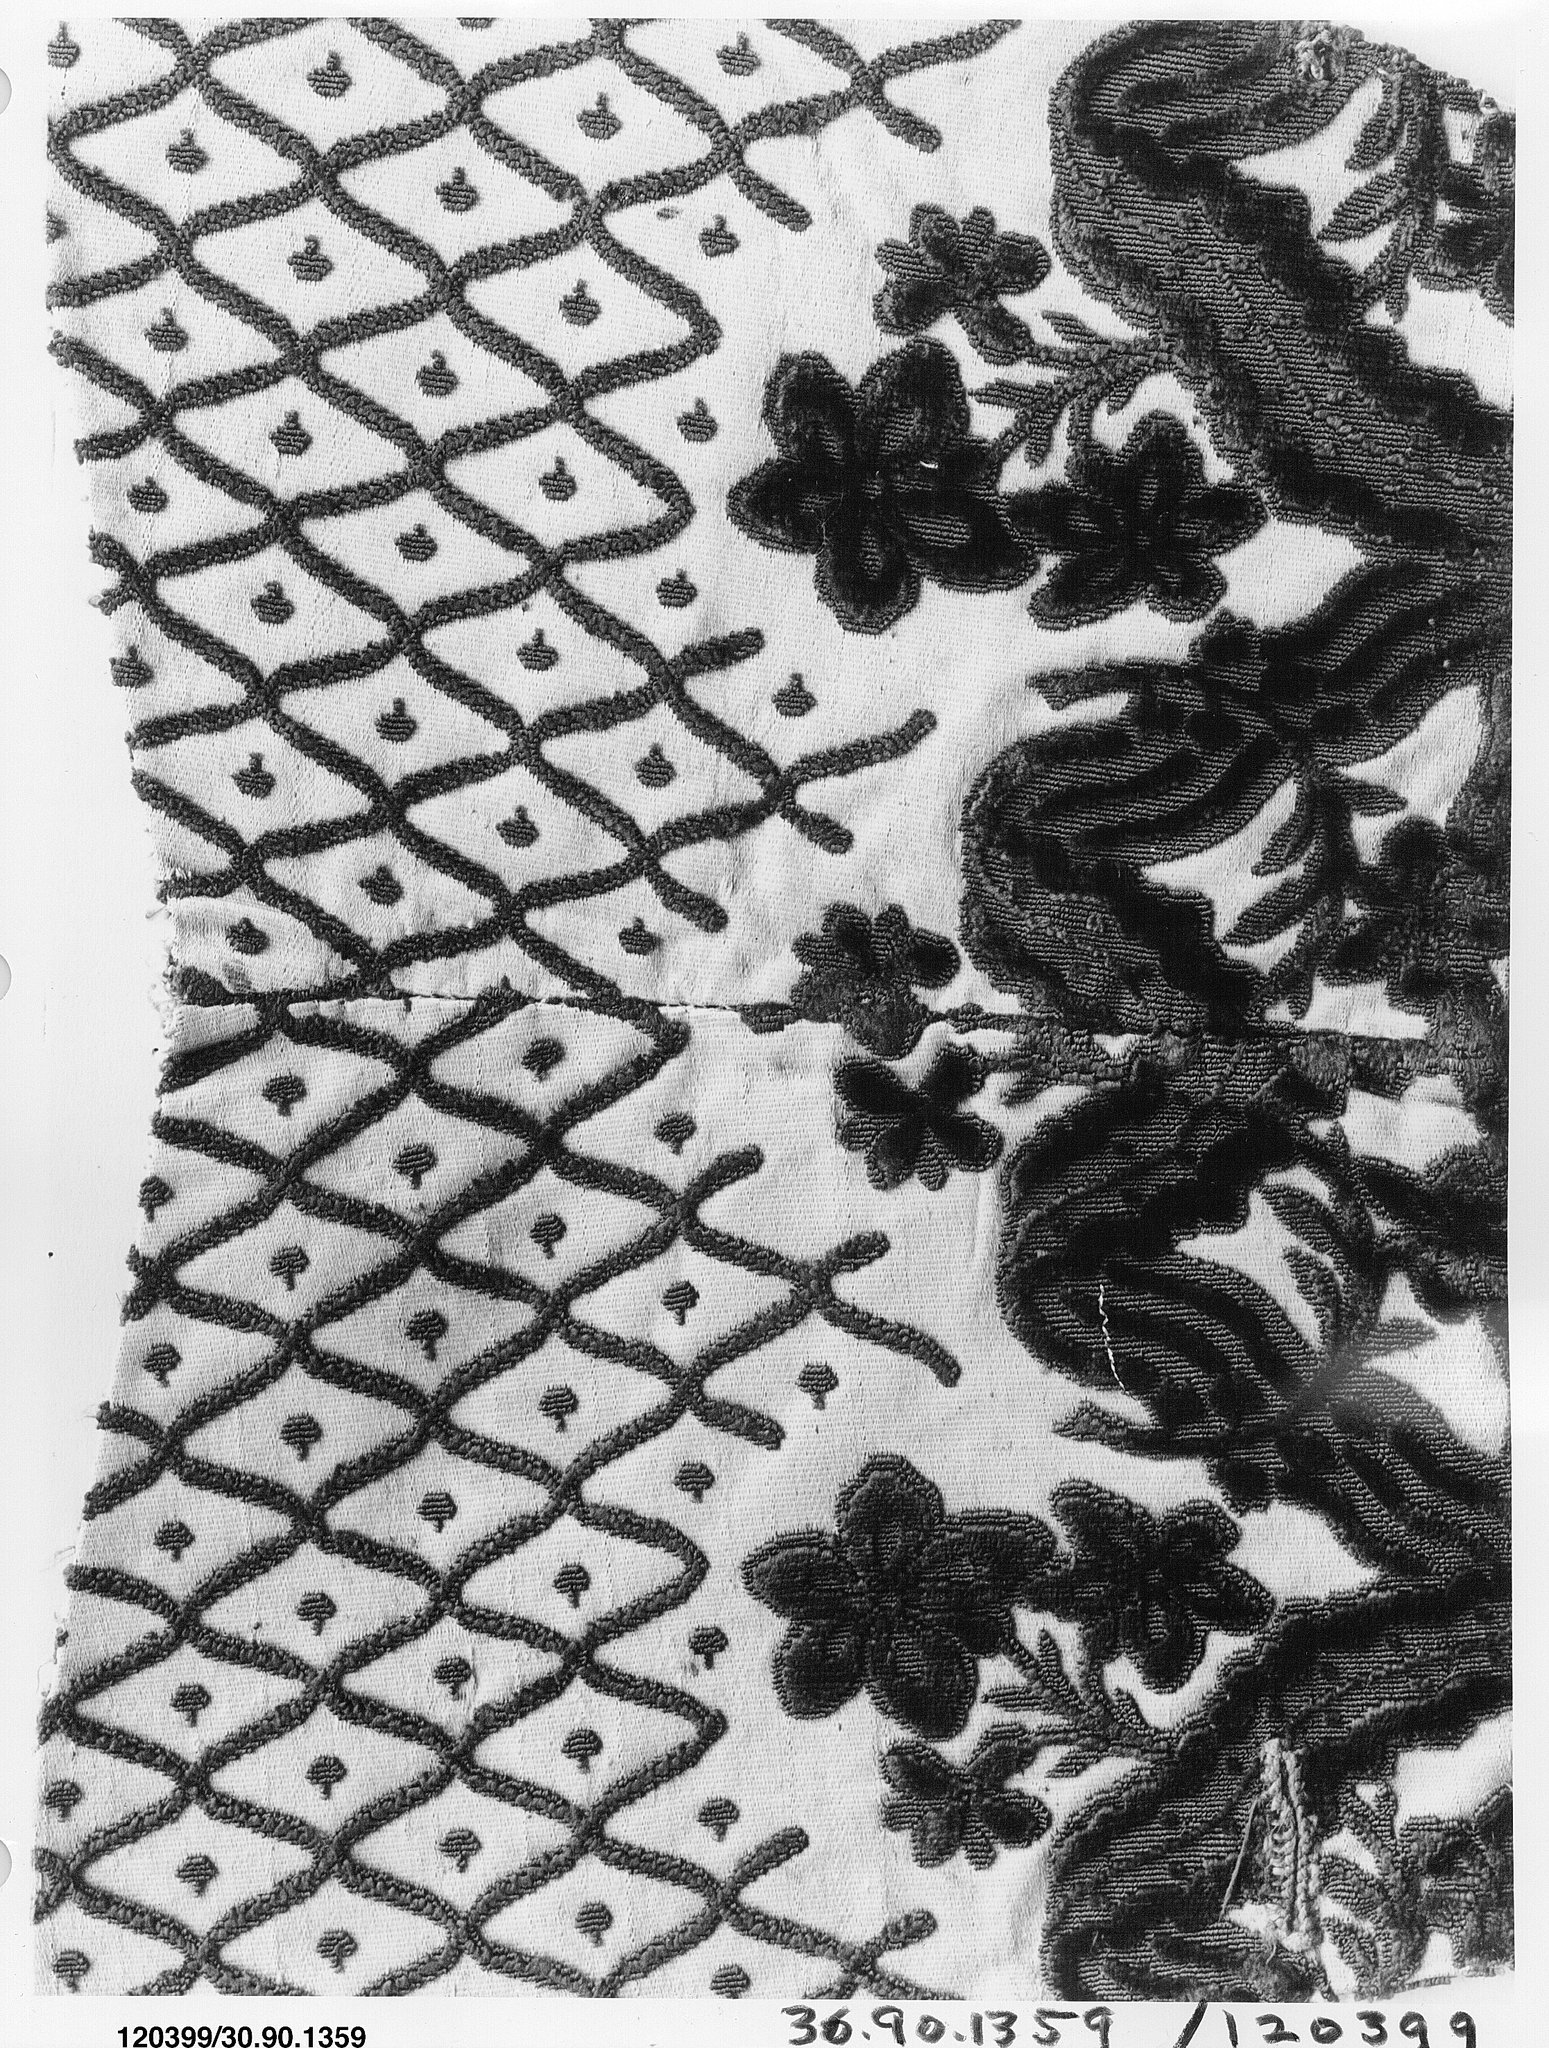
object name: piece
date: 1701-1800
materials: silk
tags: flowers